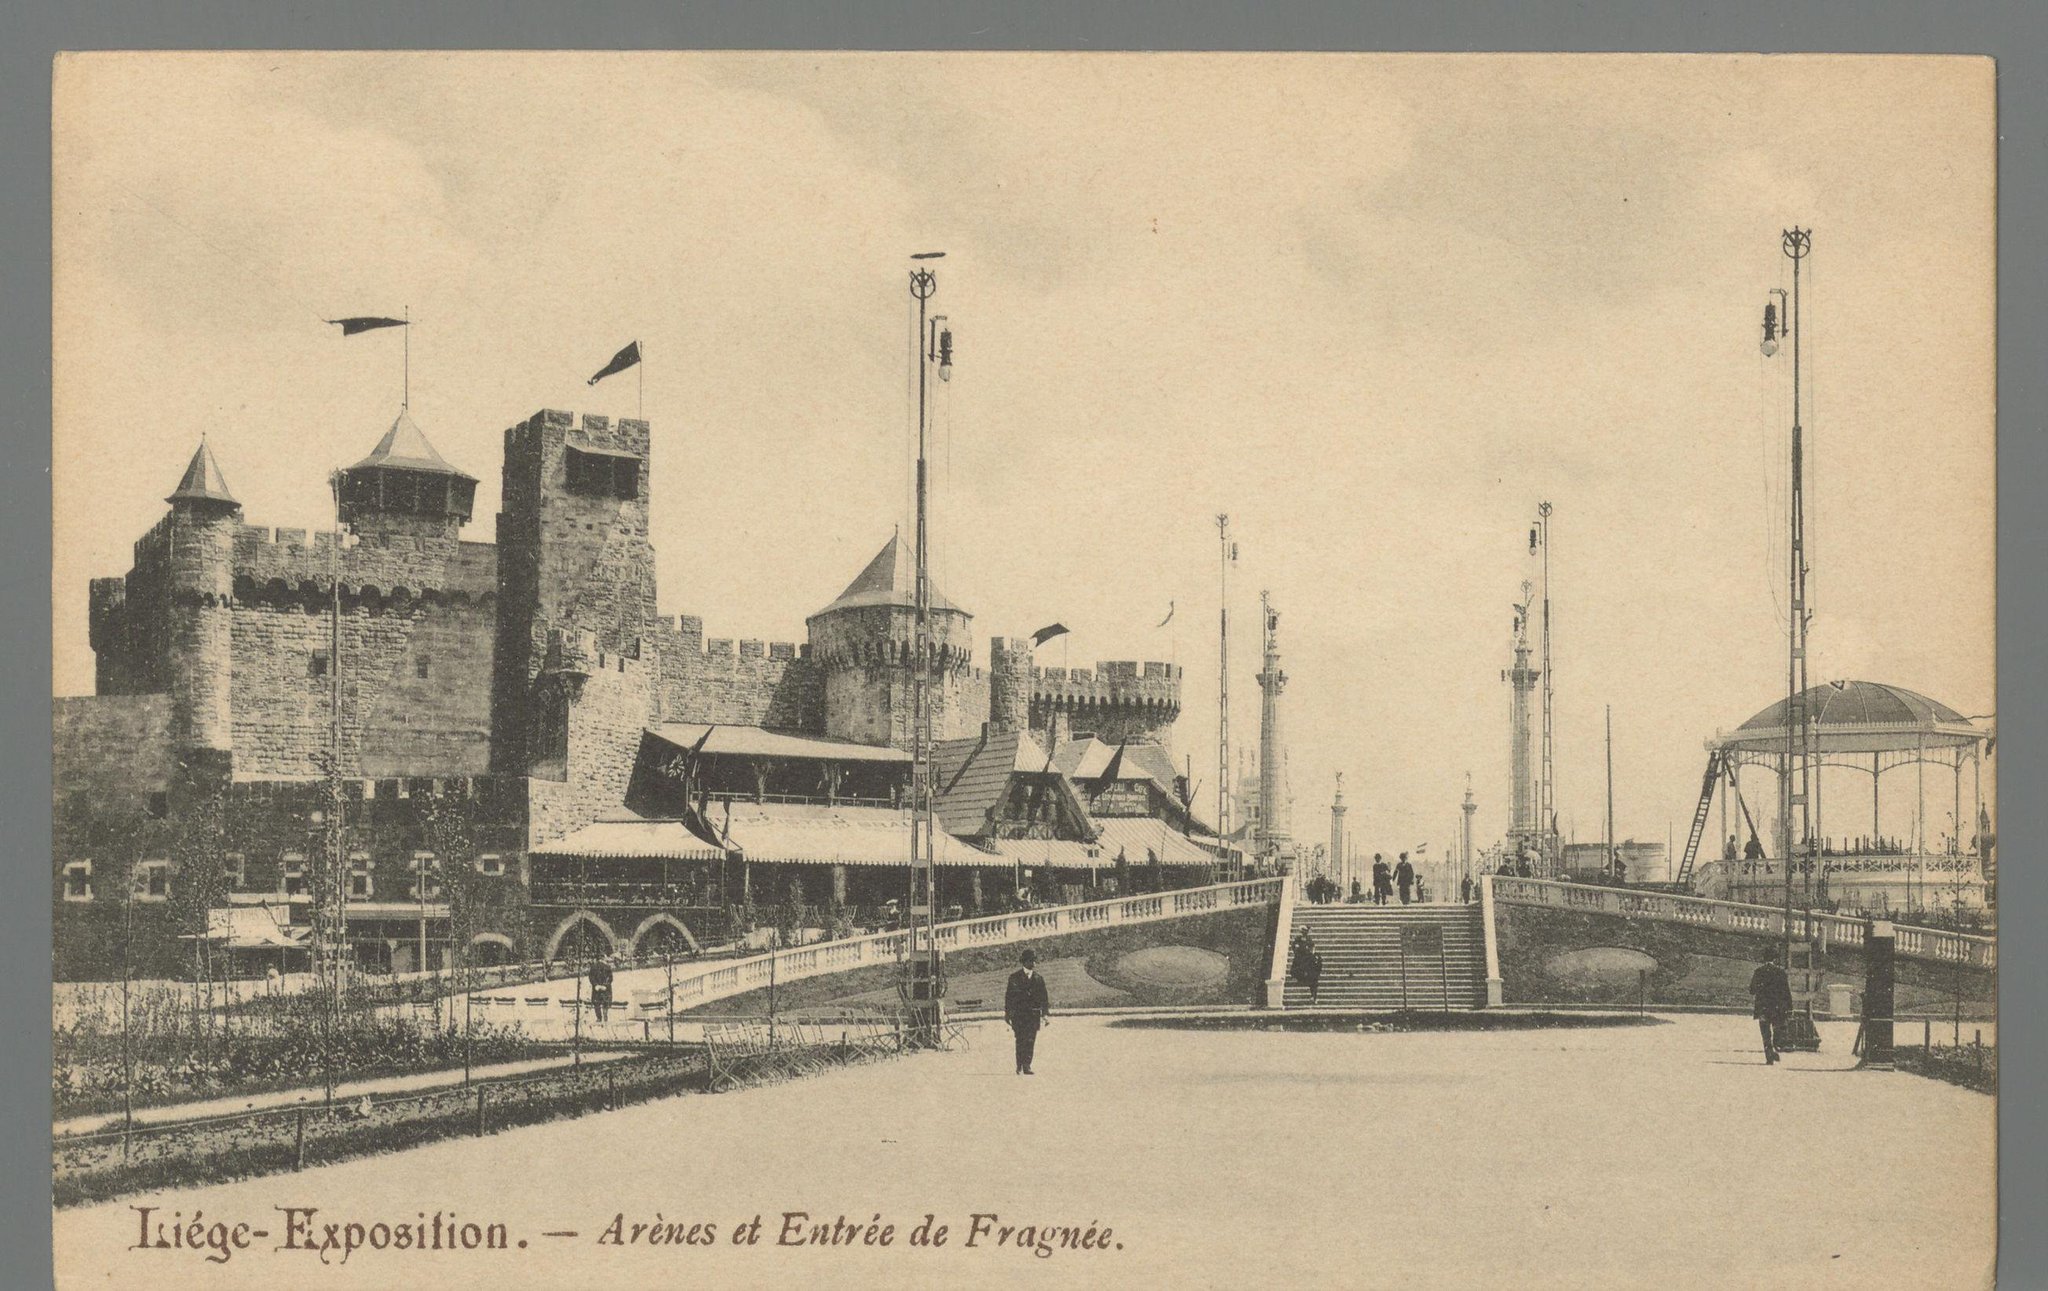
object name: photomechanical print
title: Liège. Exposition.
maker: Anonymous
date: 1905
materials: cardboard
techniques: photograph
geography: liège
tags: world fair, world exhibition, gate, entrance, liège